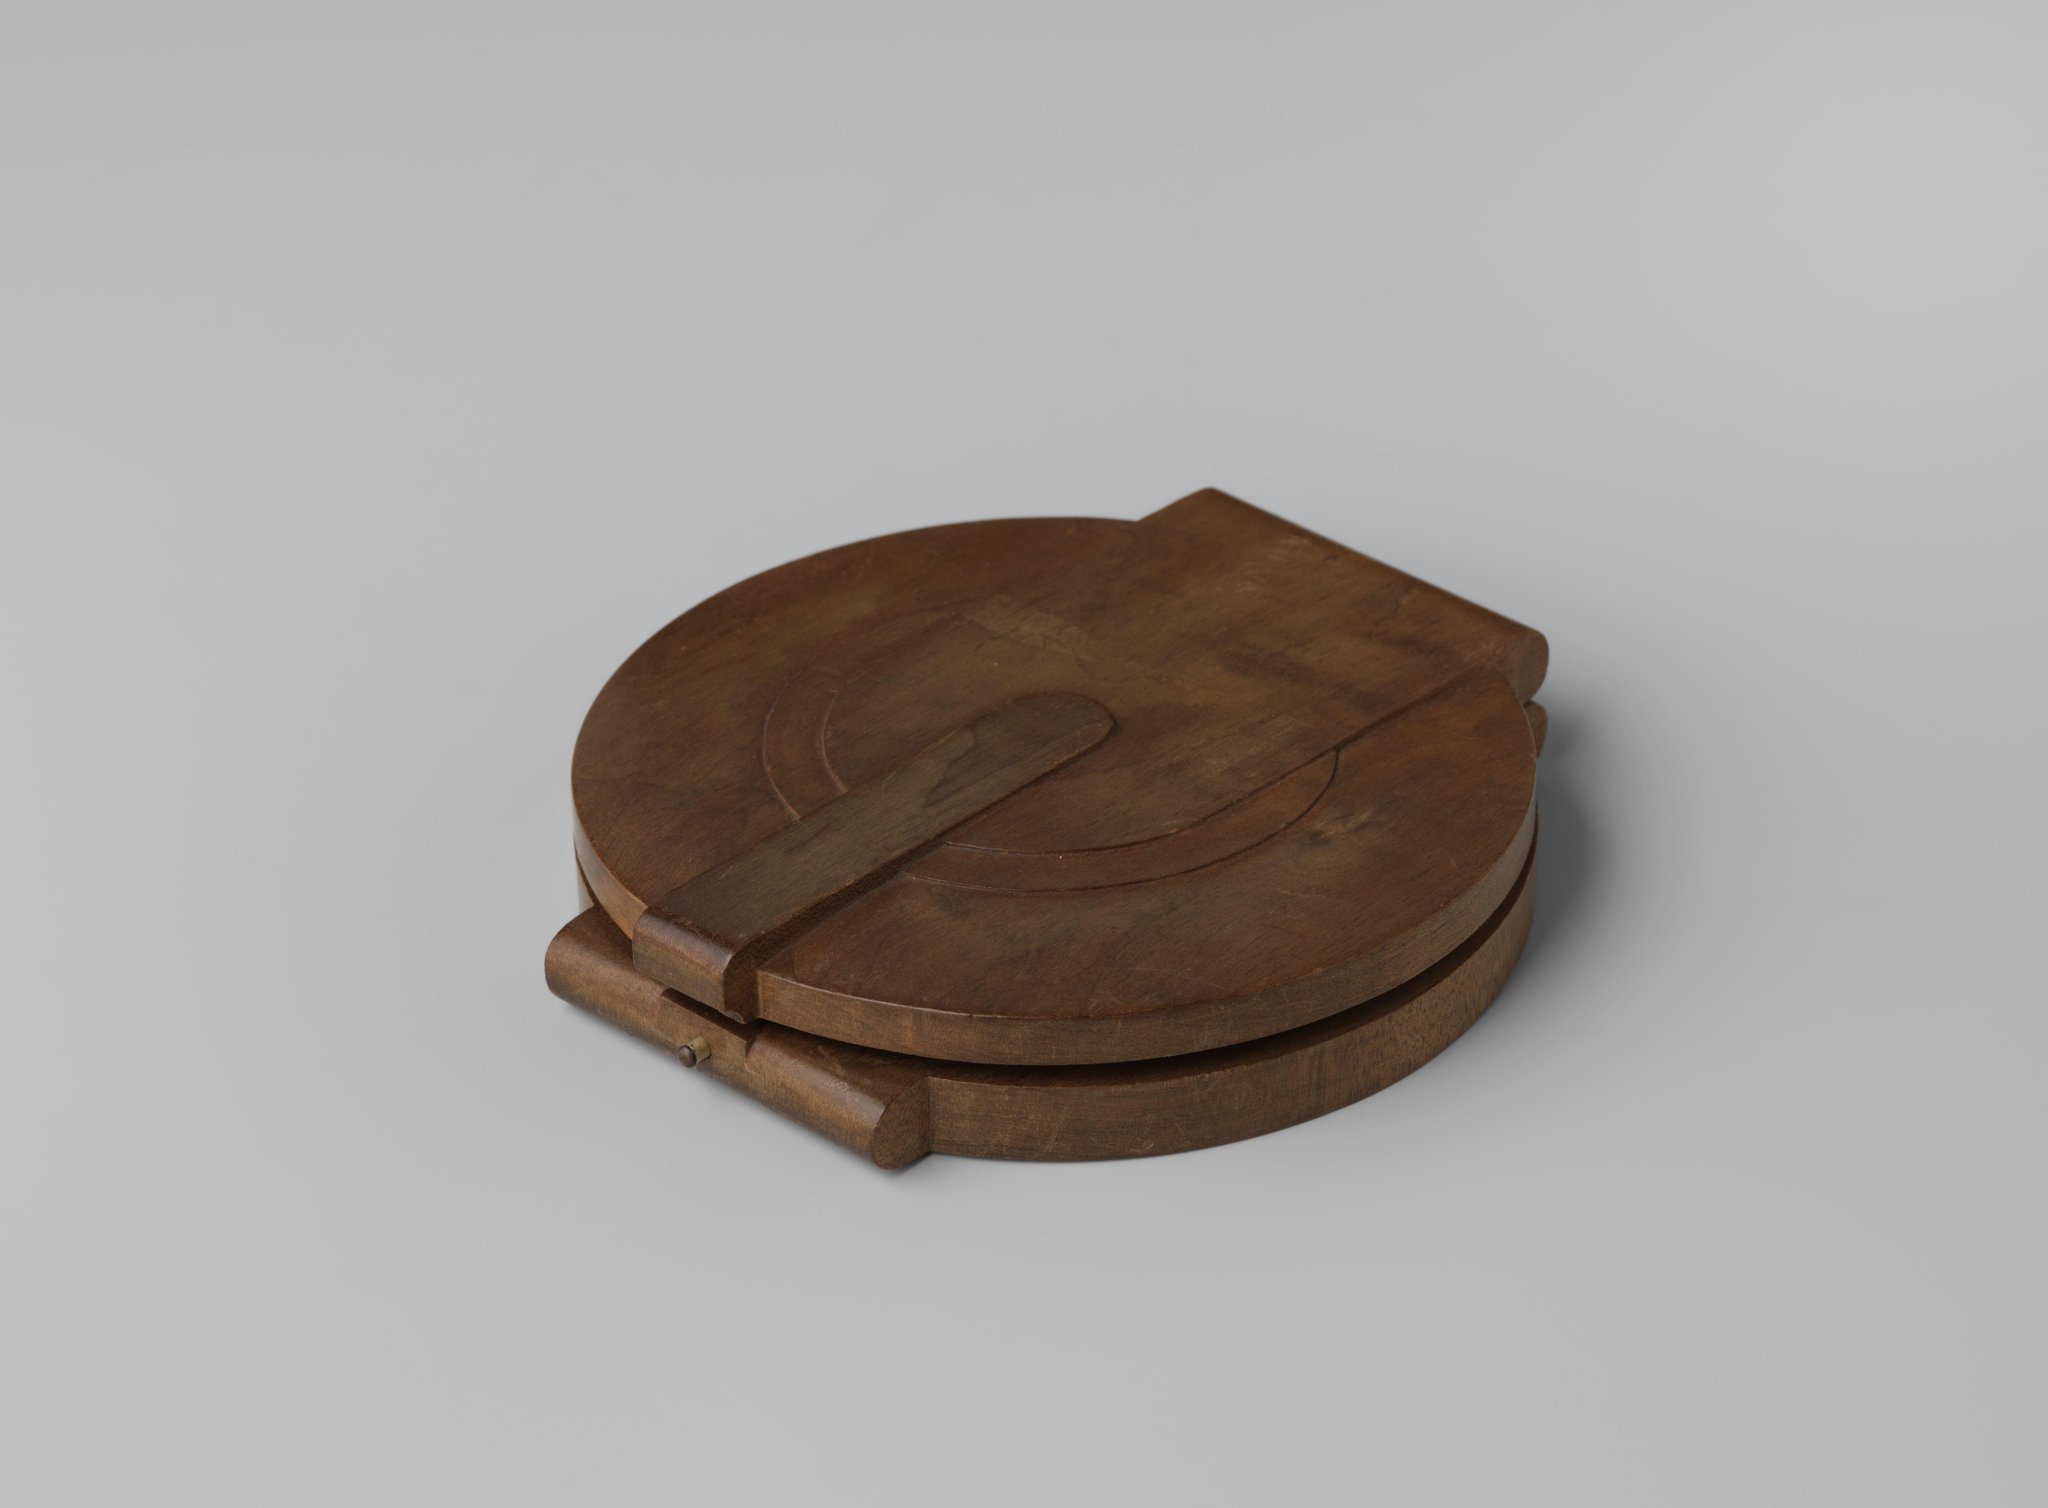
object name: box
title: Medal of Honour from the State-owned Enterprise PTT awarded to Marinus W. Bos in 1942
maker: leendert bolle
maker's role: painter, sculptor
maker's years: 1879-1942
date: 1940-1942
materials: silver, wood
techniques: striking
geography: netherlands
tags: ptt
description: Een (als een radio?) gestileerde houten doos, met openscharnierende klep, met sluiting.